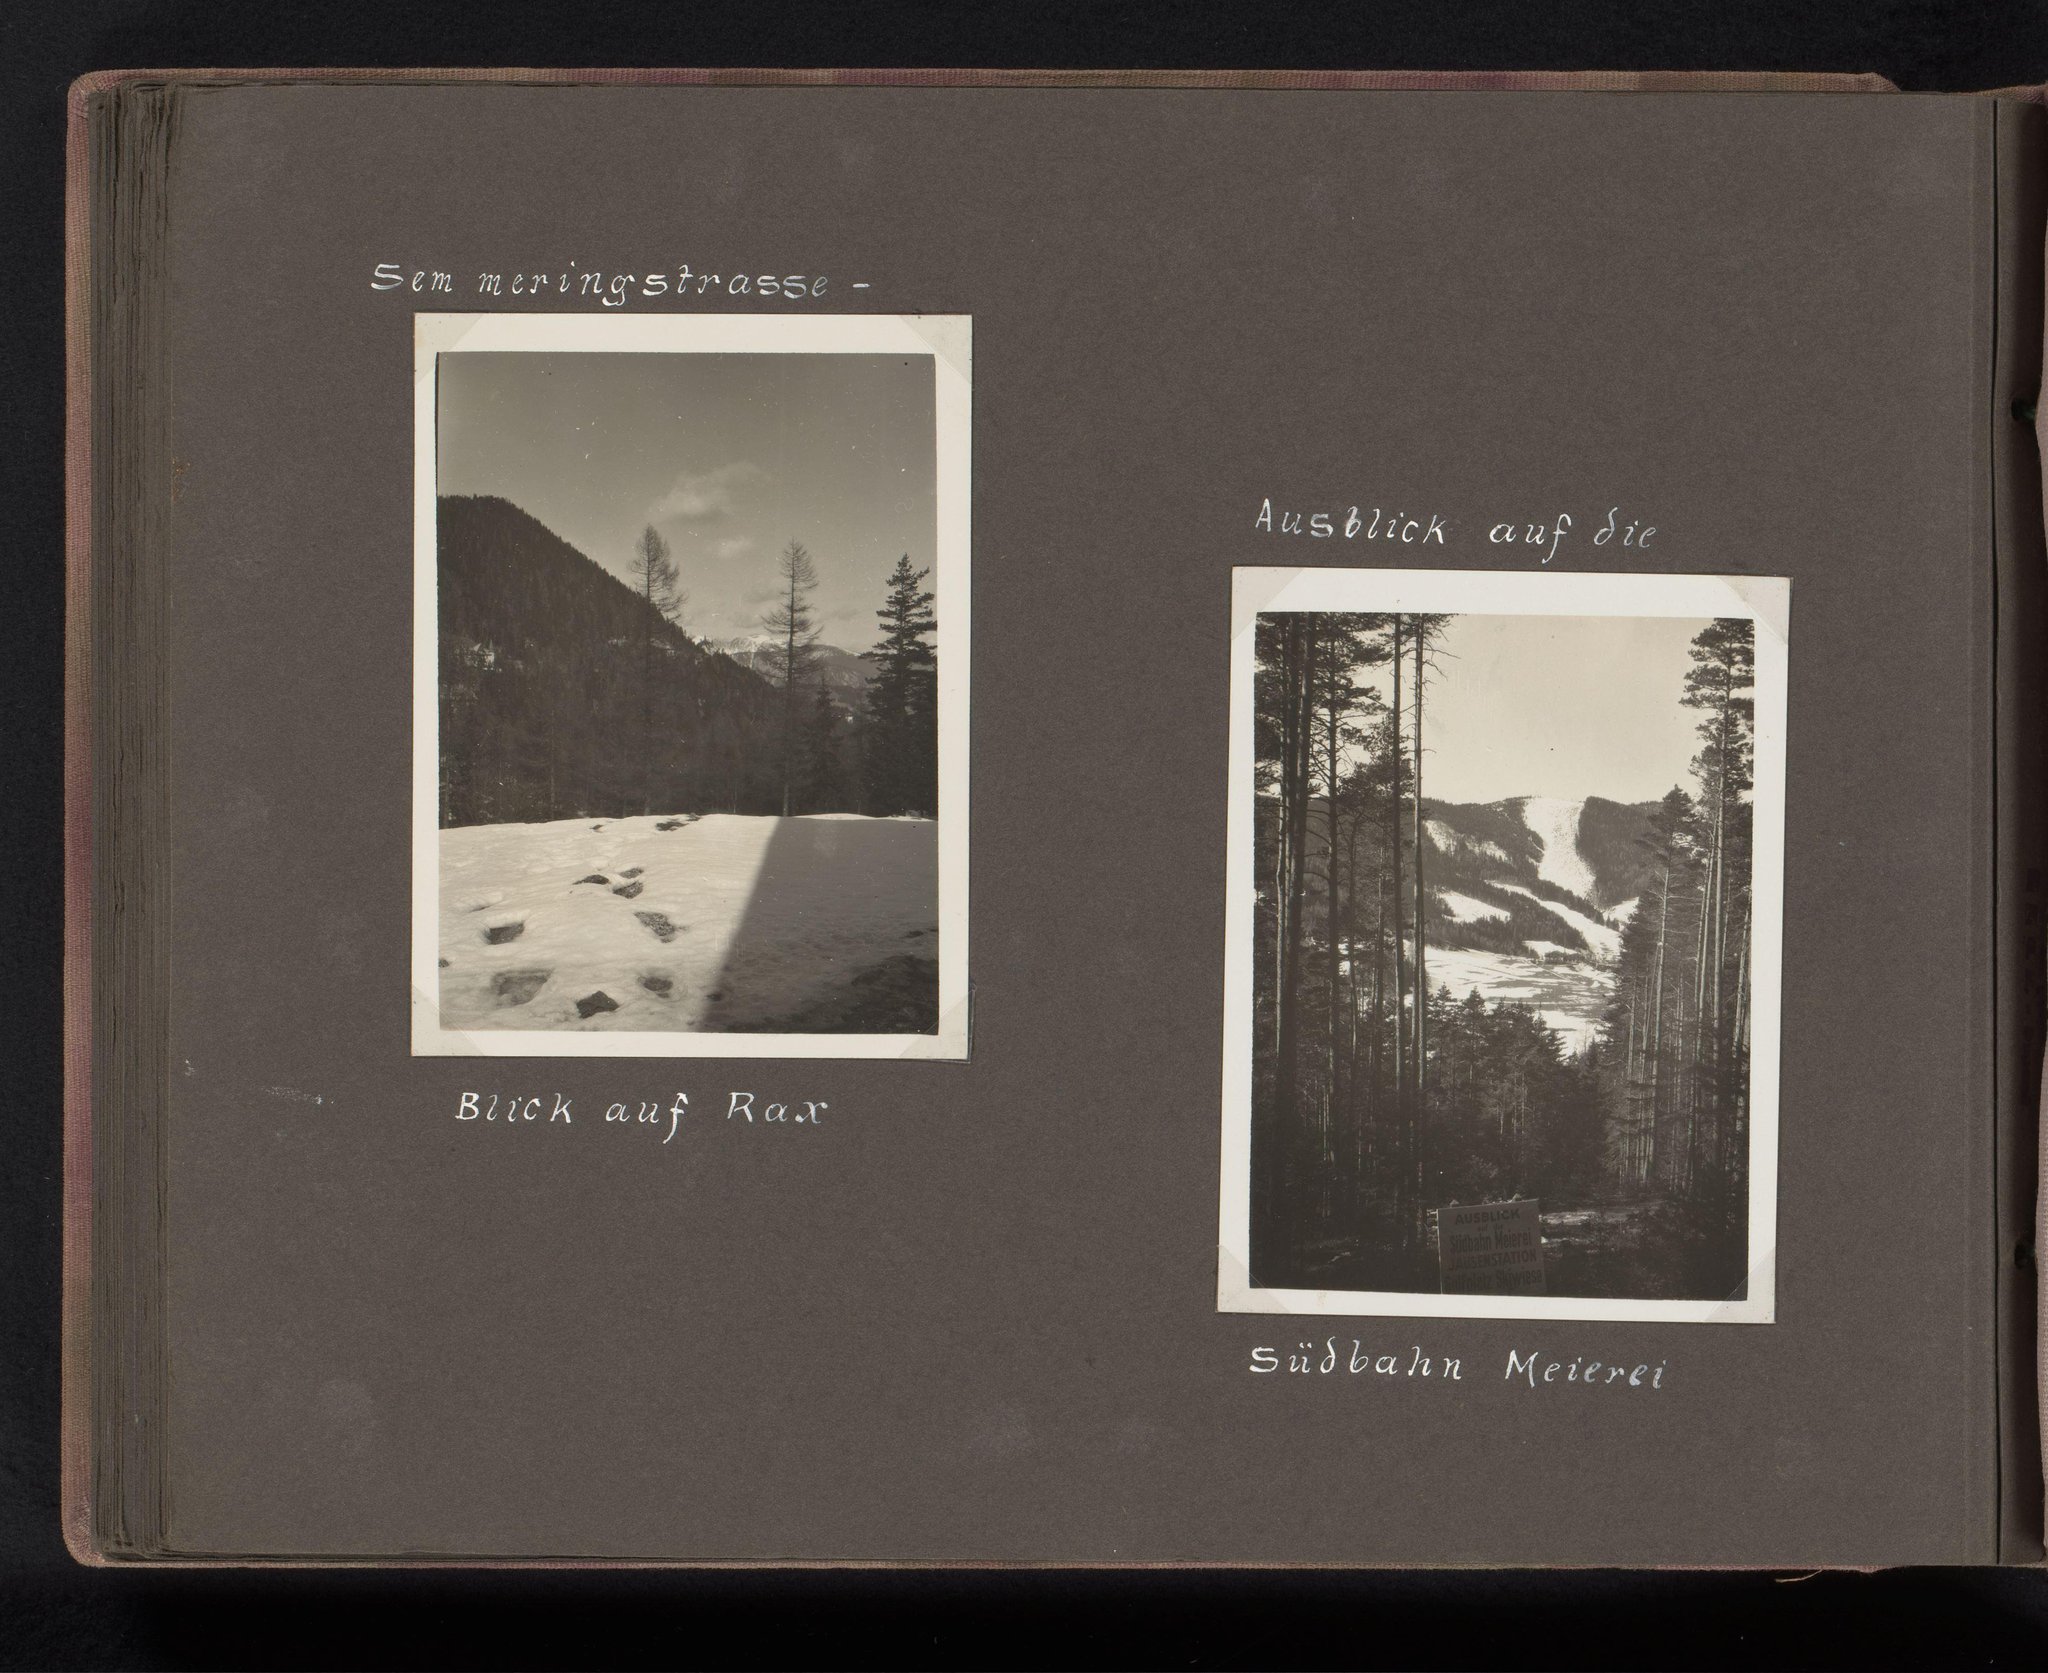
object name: photograph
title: Wintersportvakantie in Semmering, Oostenrijk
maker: berti hoppe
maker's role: fotograaf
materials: cardboard, photographic support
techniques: gelatin silver print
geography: semmering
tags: winter landscape; landscape symbolizing winter (the four seasons of the year), farm or solitary house in landscape, mountains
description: Twee winterlandschappen in Semmering, waarvan één met een gebouw. In de onderschriften is vermeld dat het gaat om een gezicht op de bergketen Rax en een gezicht op de boerderij van het Südbahnhotel. Deze foto's maken deel uit van een album.